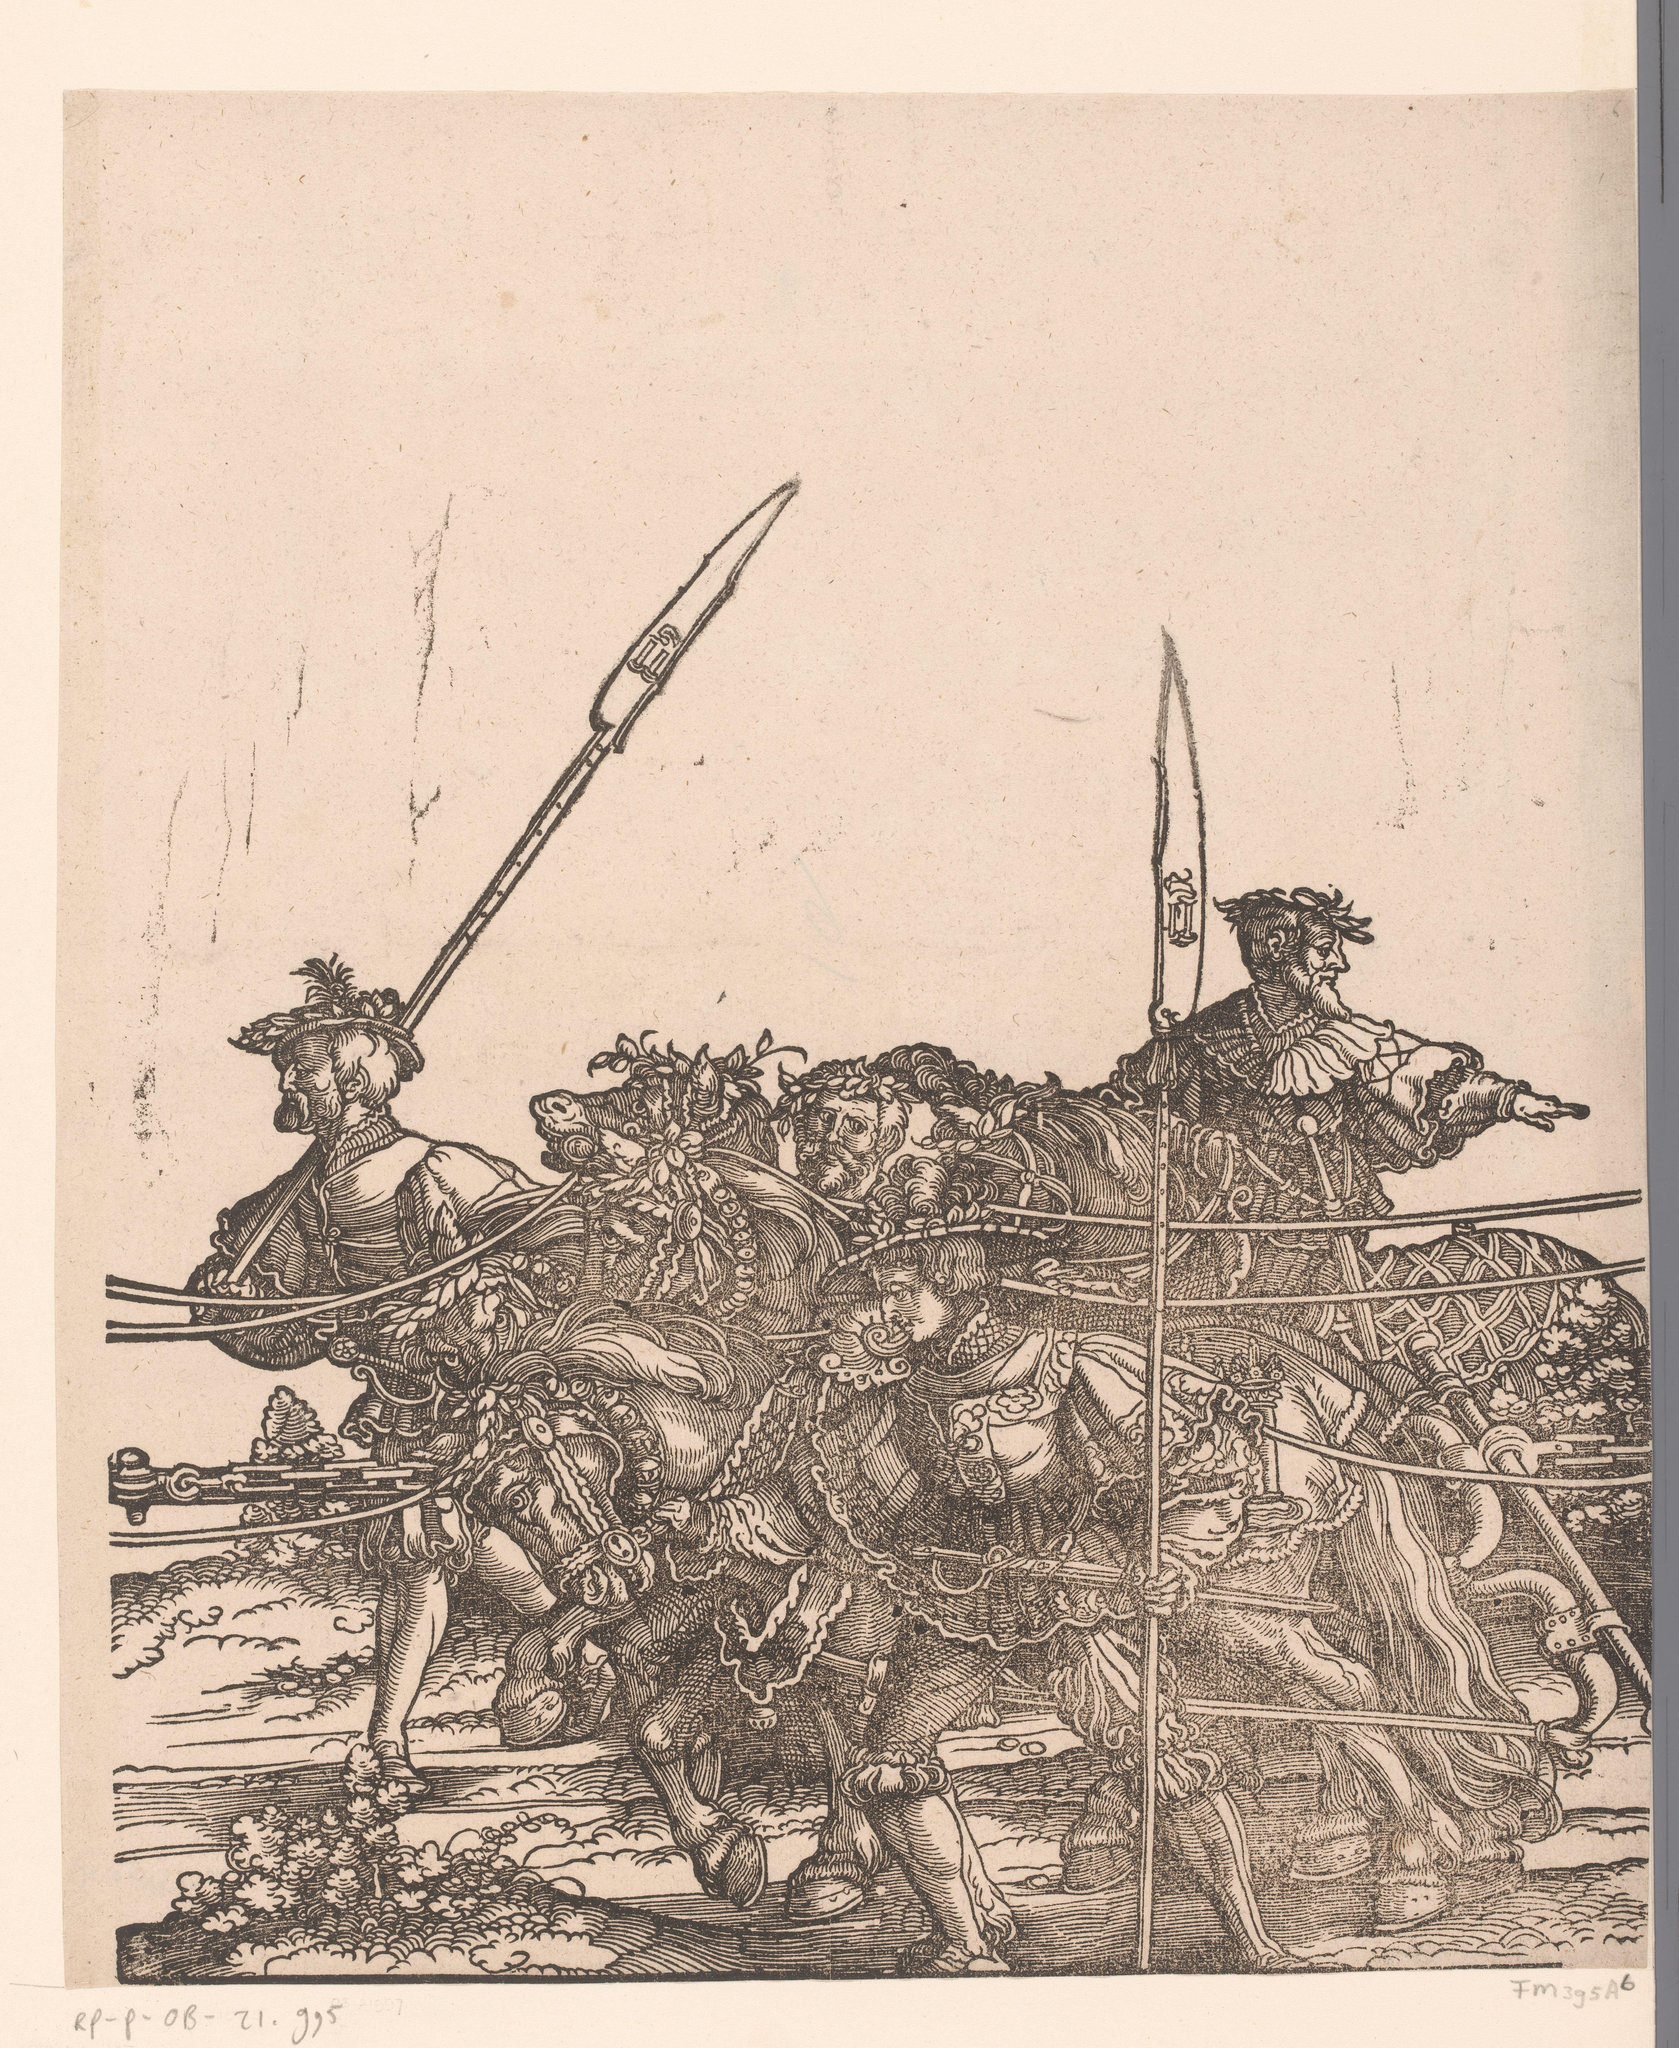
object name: print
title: Triomfoptocht van keizer Karel V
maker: Anonymous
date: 1537-1551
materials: paper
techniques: woodcut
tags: ghent, charles v (holy roman emperor and king of spain), triumphal entry and public reception, pageant, 'entrée solennelle', 'joyeuse entrée'